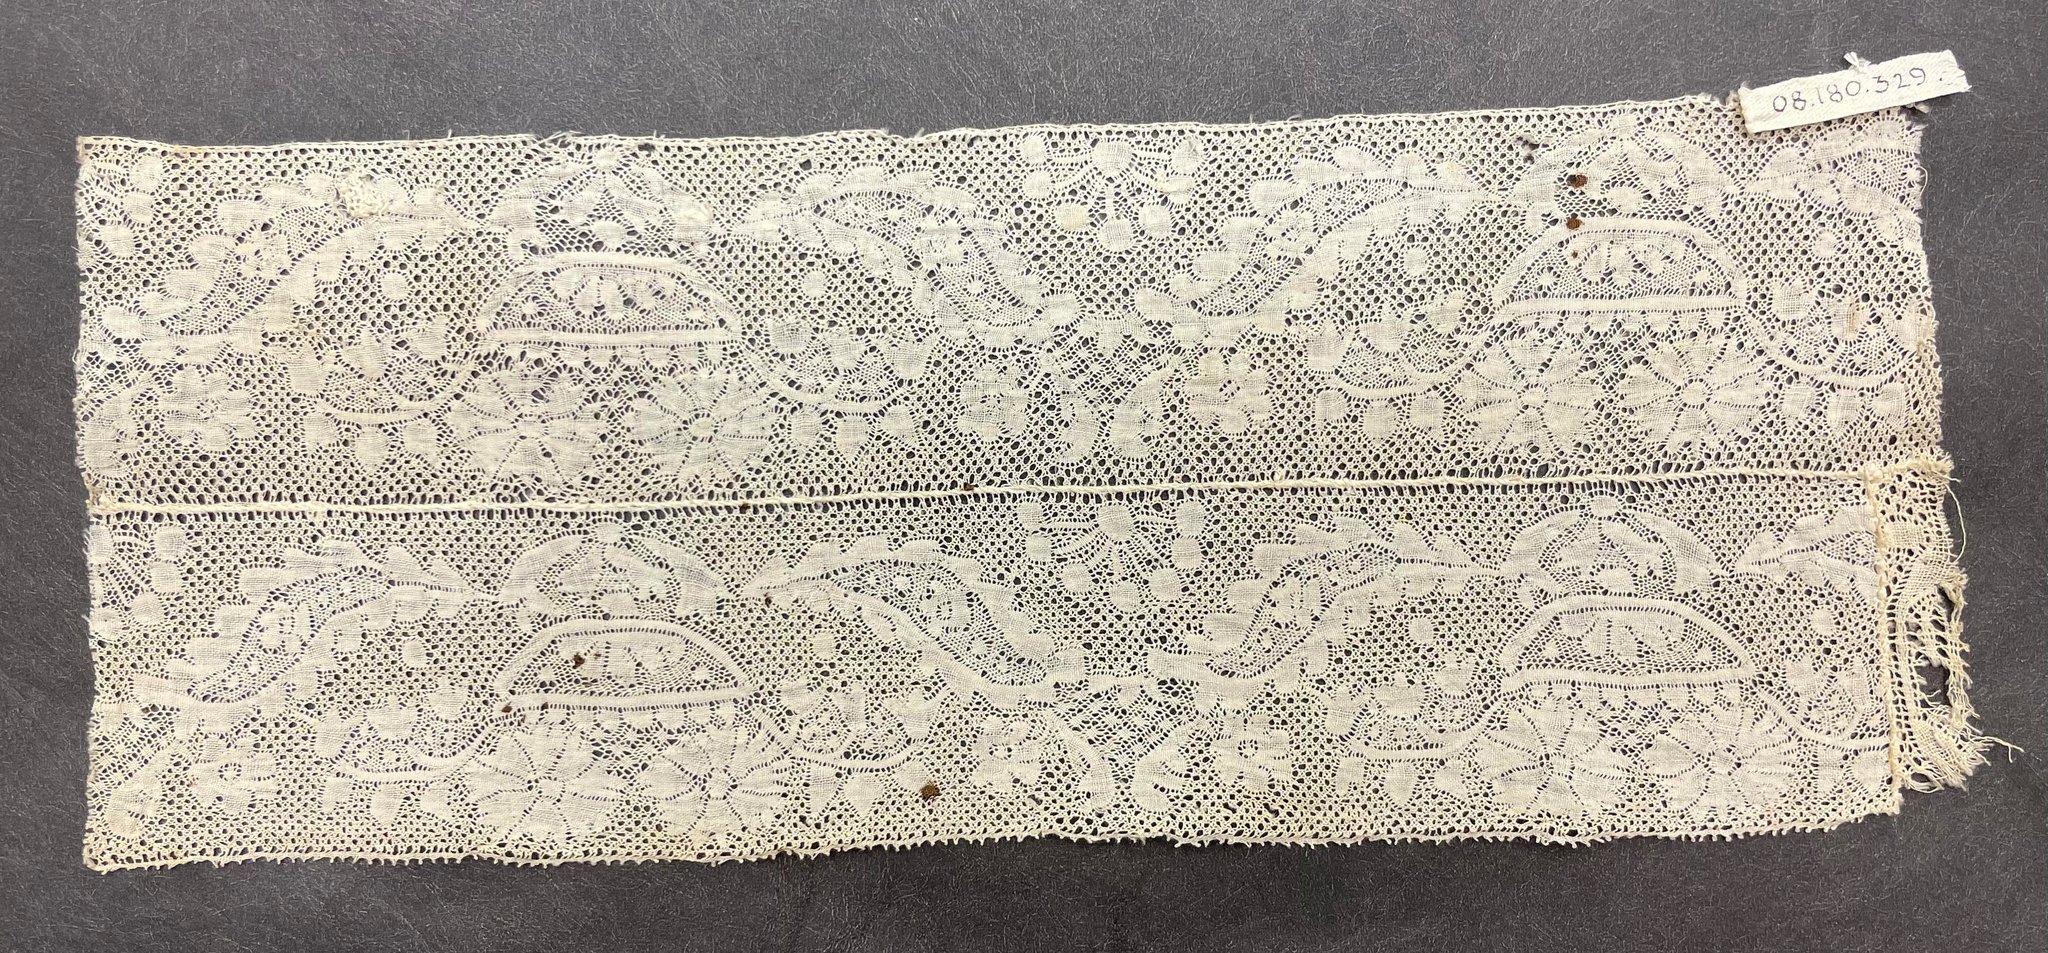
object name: piece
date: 1701-1800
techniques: lace